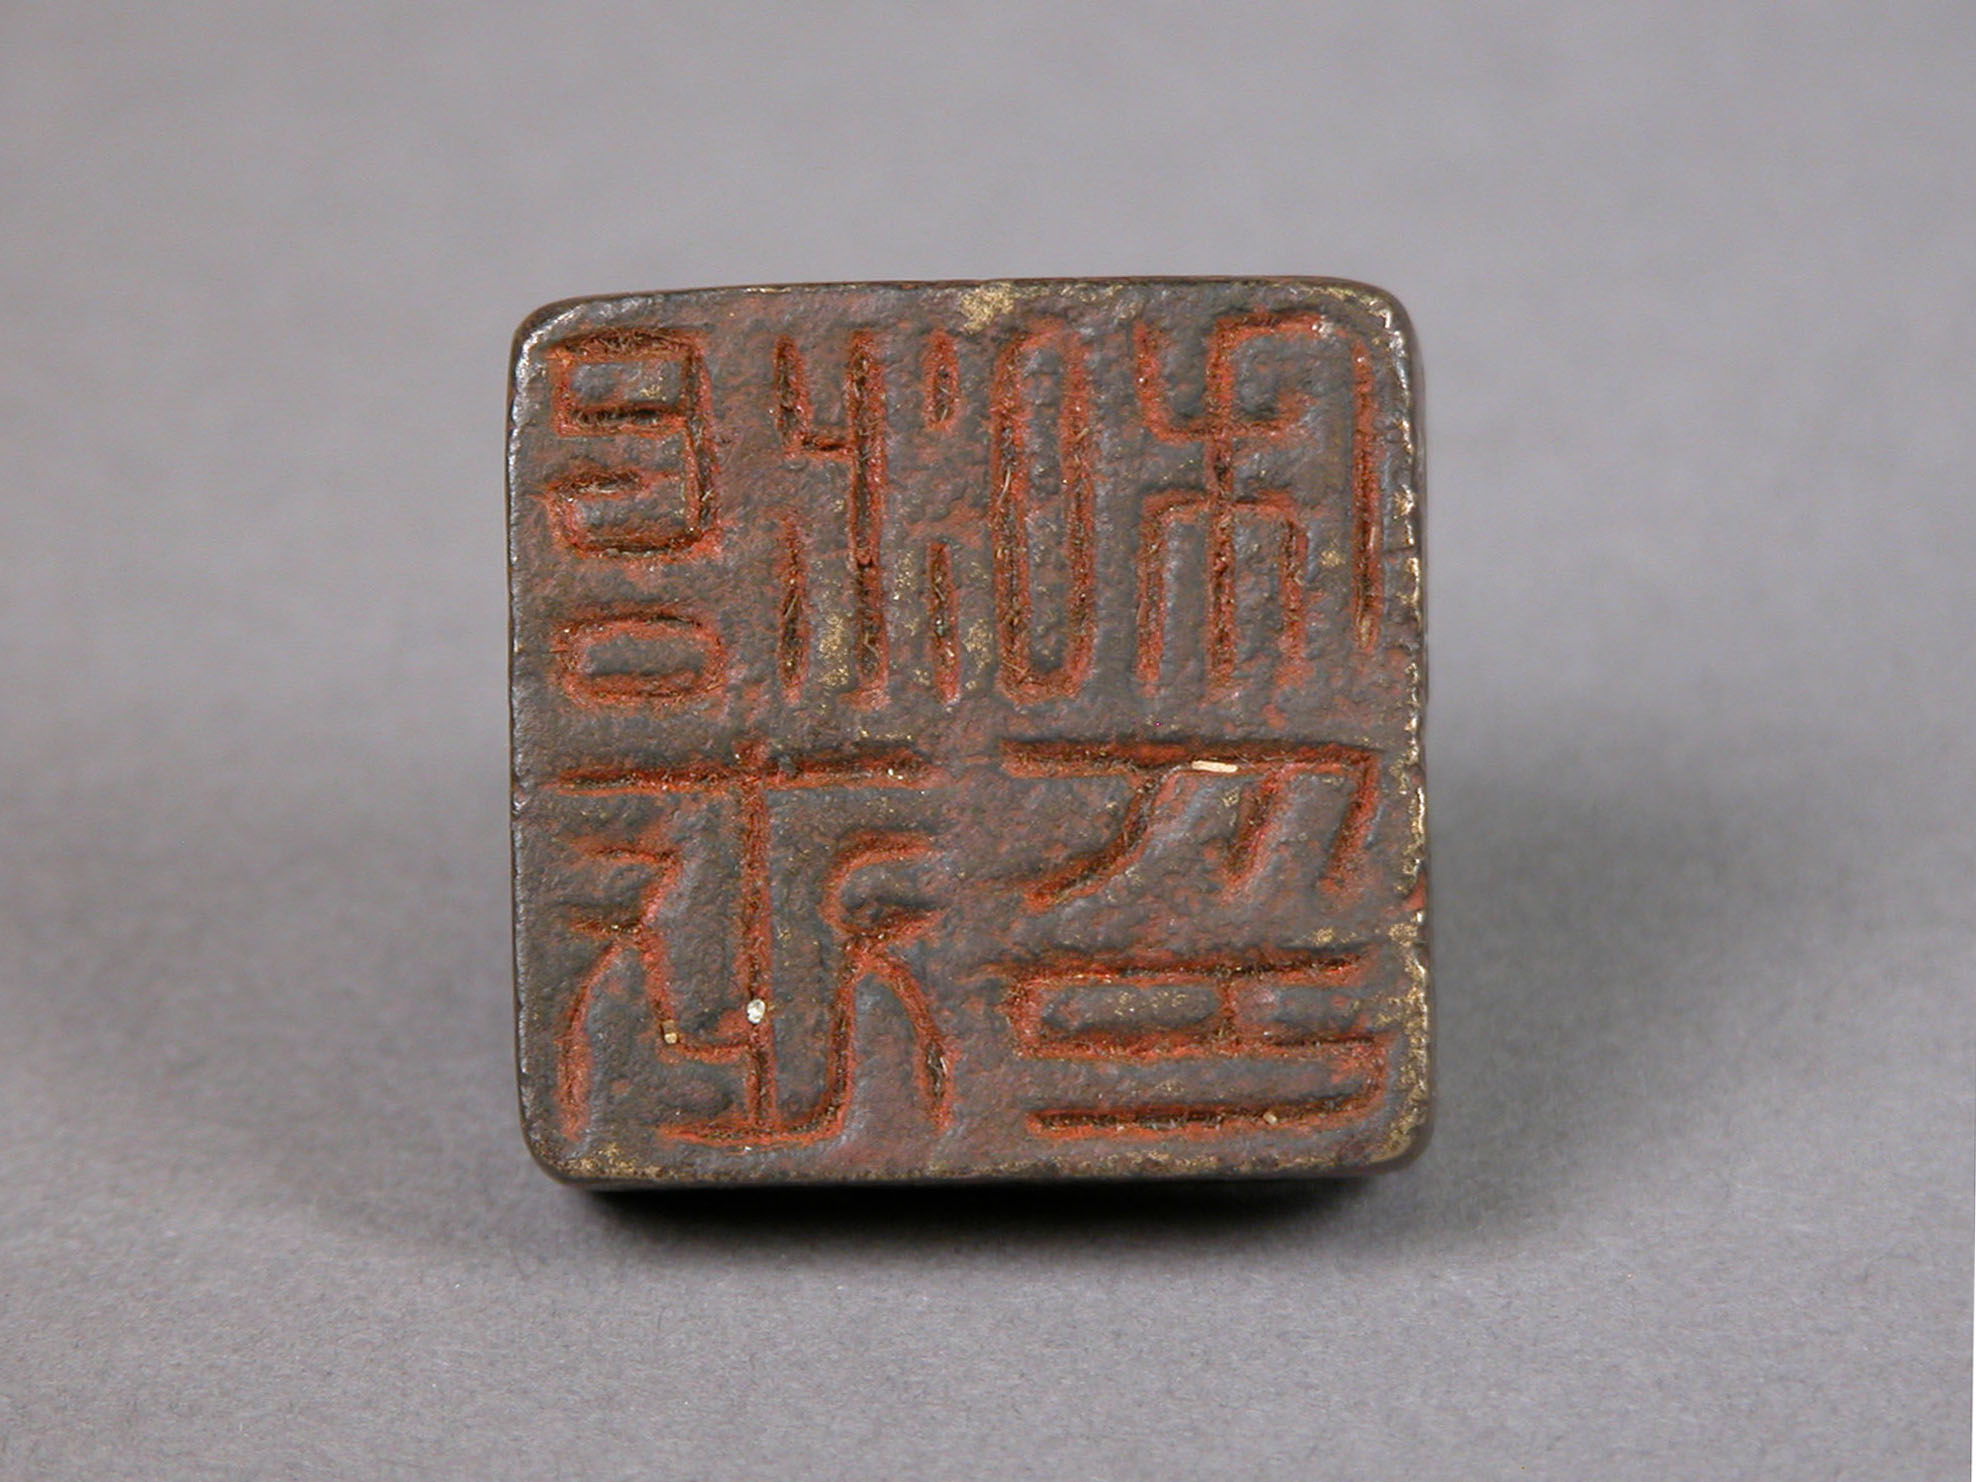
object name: seal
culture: chinese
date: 1300-1644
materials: bronze